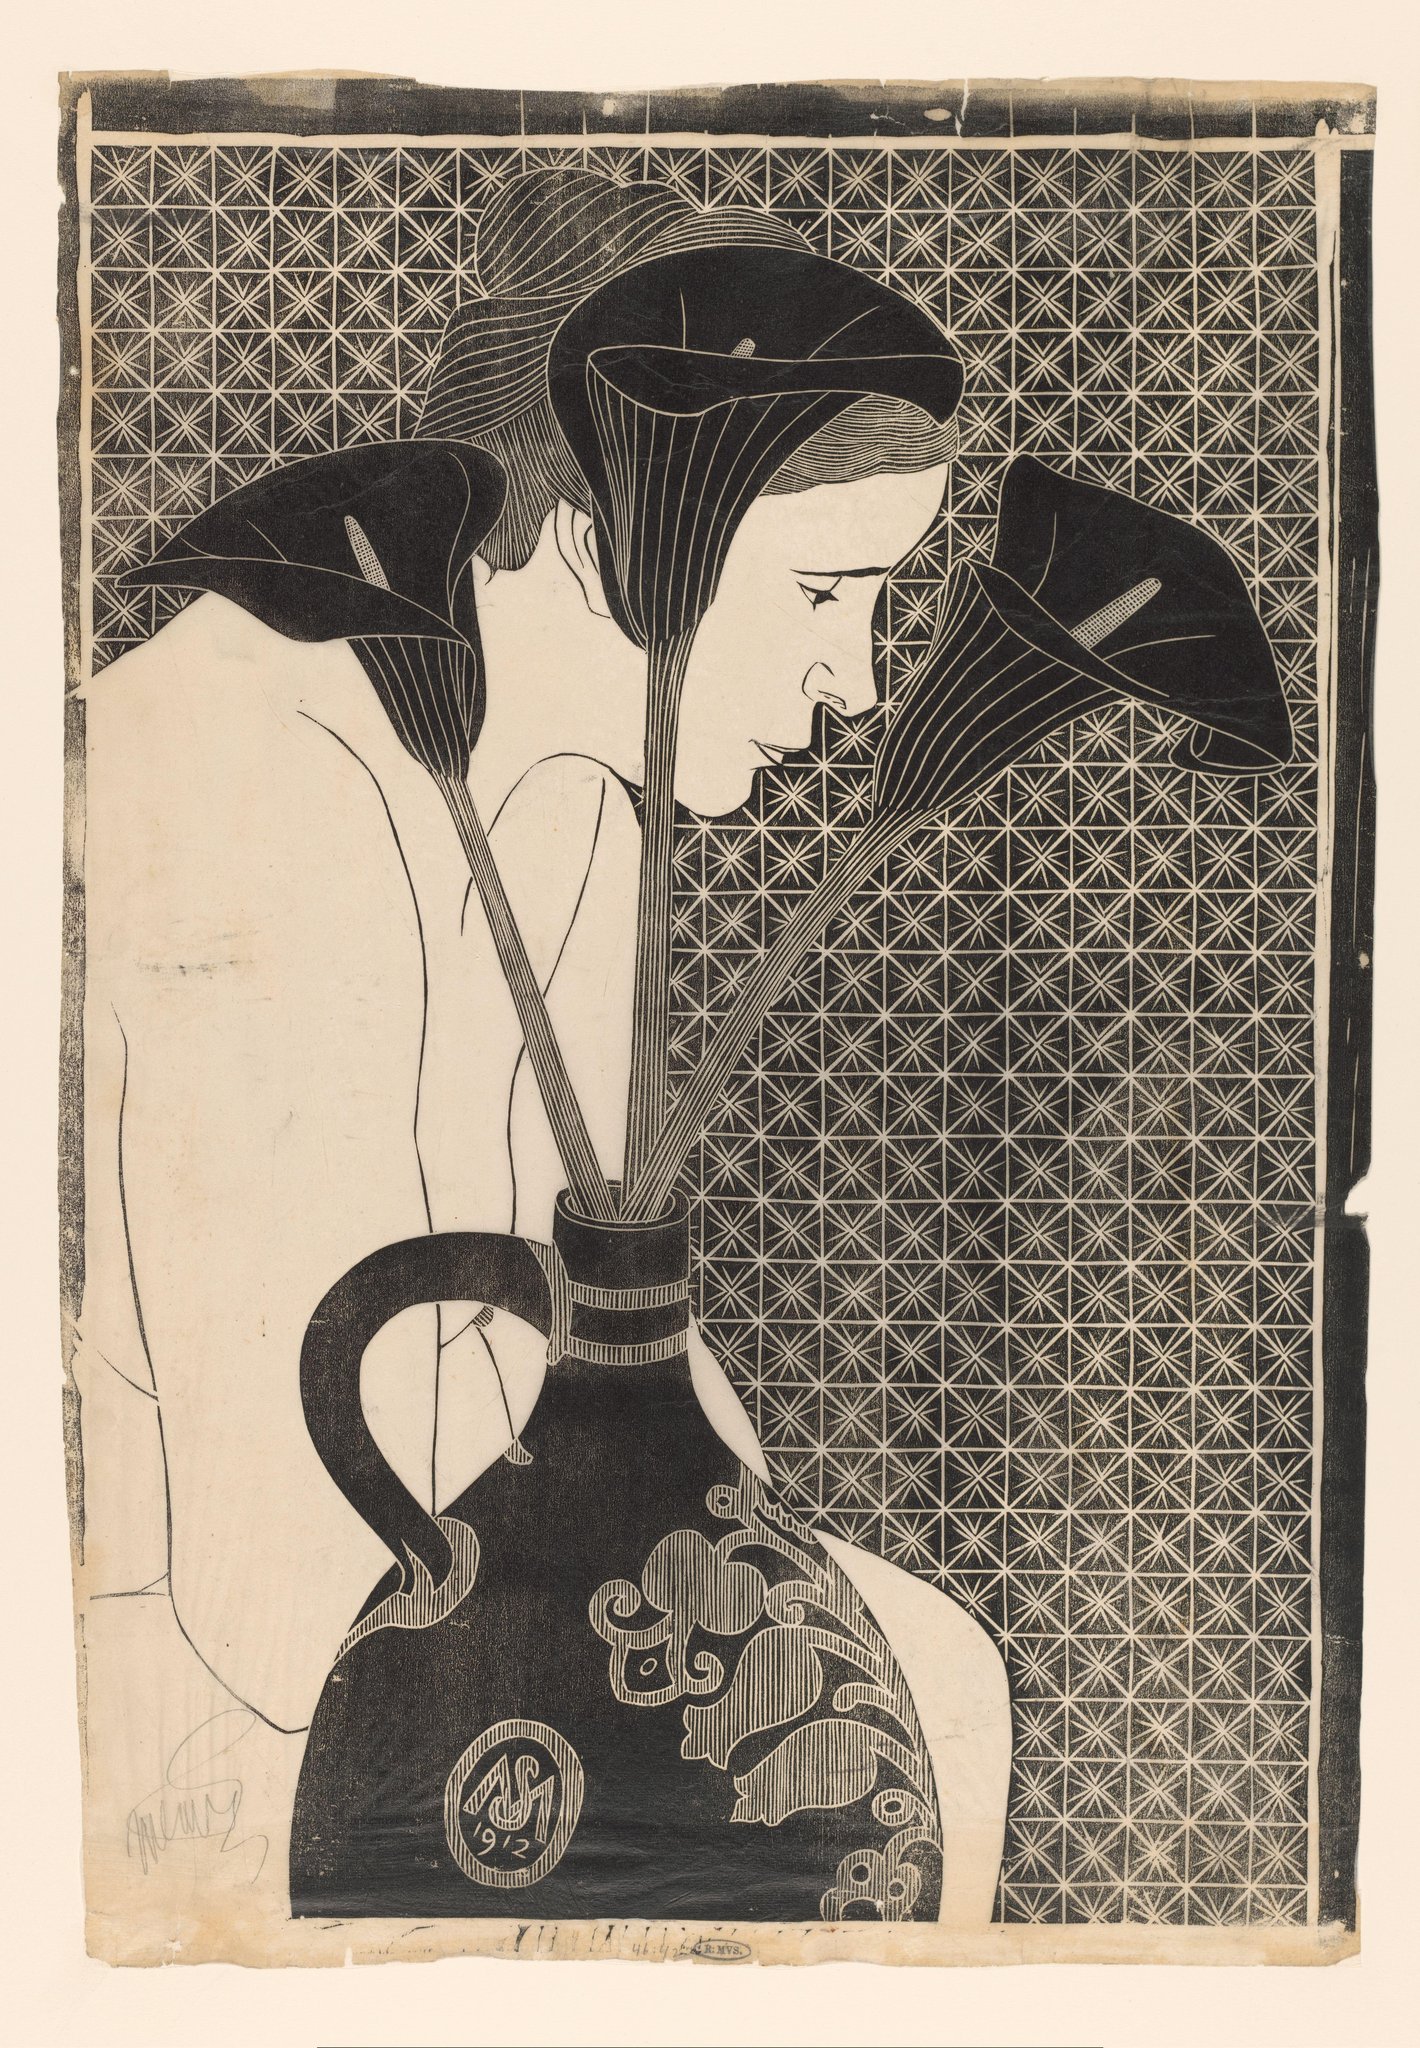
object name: print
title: Zwarte Aronskelken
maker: samuel jessurun de mesquita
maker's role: draughtsman, print maker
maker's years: 1868-1944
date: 1912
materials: paper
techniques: woodcut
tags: flowers, the (nude) human figure; 'corpo humano' (ripa) - aa - female human figure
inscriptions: collector's mark: Lugt 2228